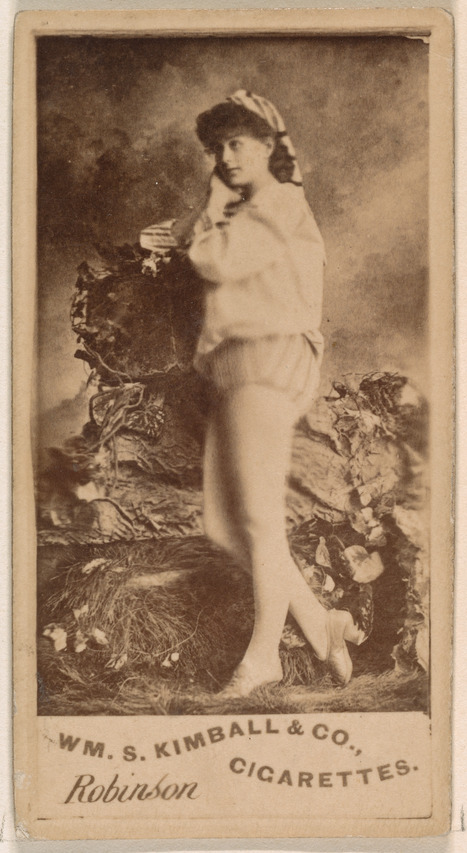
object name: photograph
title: Miss Robinson, from the Actresses series (N203) issued by Wm. S. Kimball & Co.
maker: william s. kimball & company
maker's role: publisher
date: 1889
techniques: color lithograph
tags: portraits,women,actresses